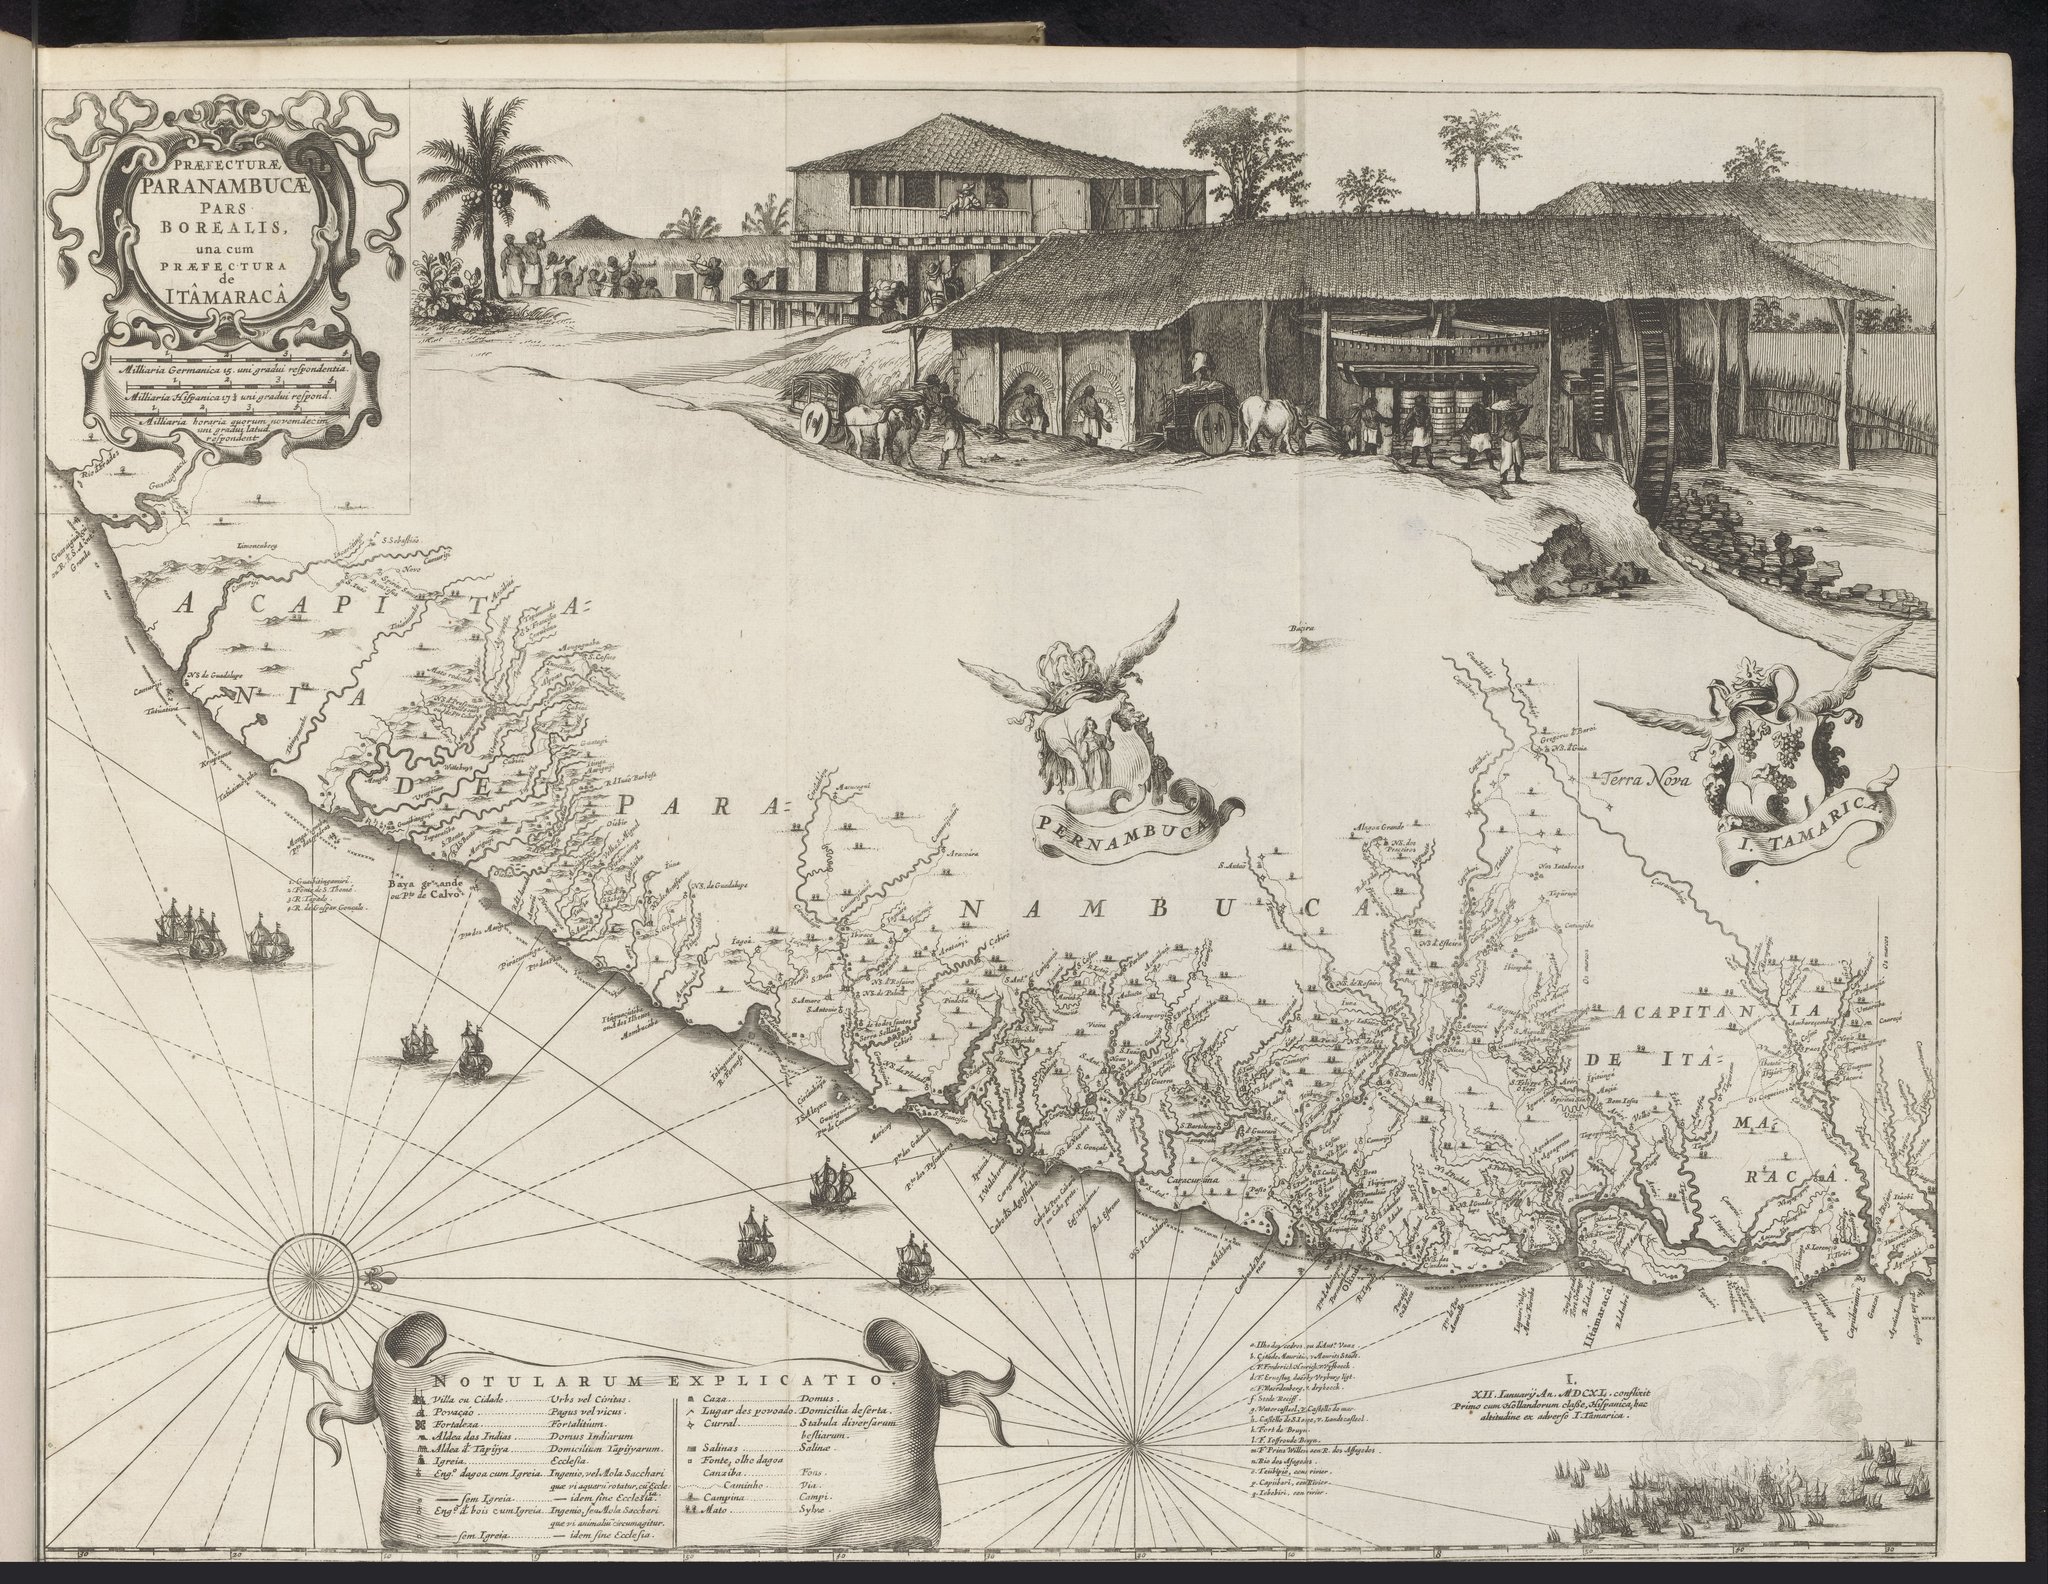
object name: map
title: Praefecturae Paranambucae pars borealis una cum praefectura de Itamaraca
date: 1645-1647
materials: paper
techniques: engraving, etching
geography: amsterdam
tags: johan maurits graaf van nassau-siegen, maps of separate countries or regions, industrial structures, watermill, tropical culture, sugar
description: Kaart van de kust van Pernambuco bij het eiland Itamaracá. Met scène van lokale suikerfabriek met een watermolen. Met de zeegevechten met de Portugezen in januari 1640. Plaat [nr. 3] in een serie van 55 voorstellingen van de tocht naar en het verblijf in Brazilië van graaf Johan Maurits van Nassau in de jaren 1636-1644.